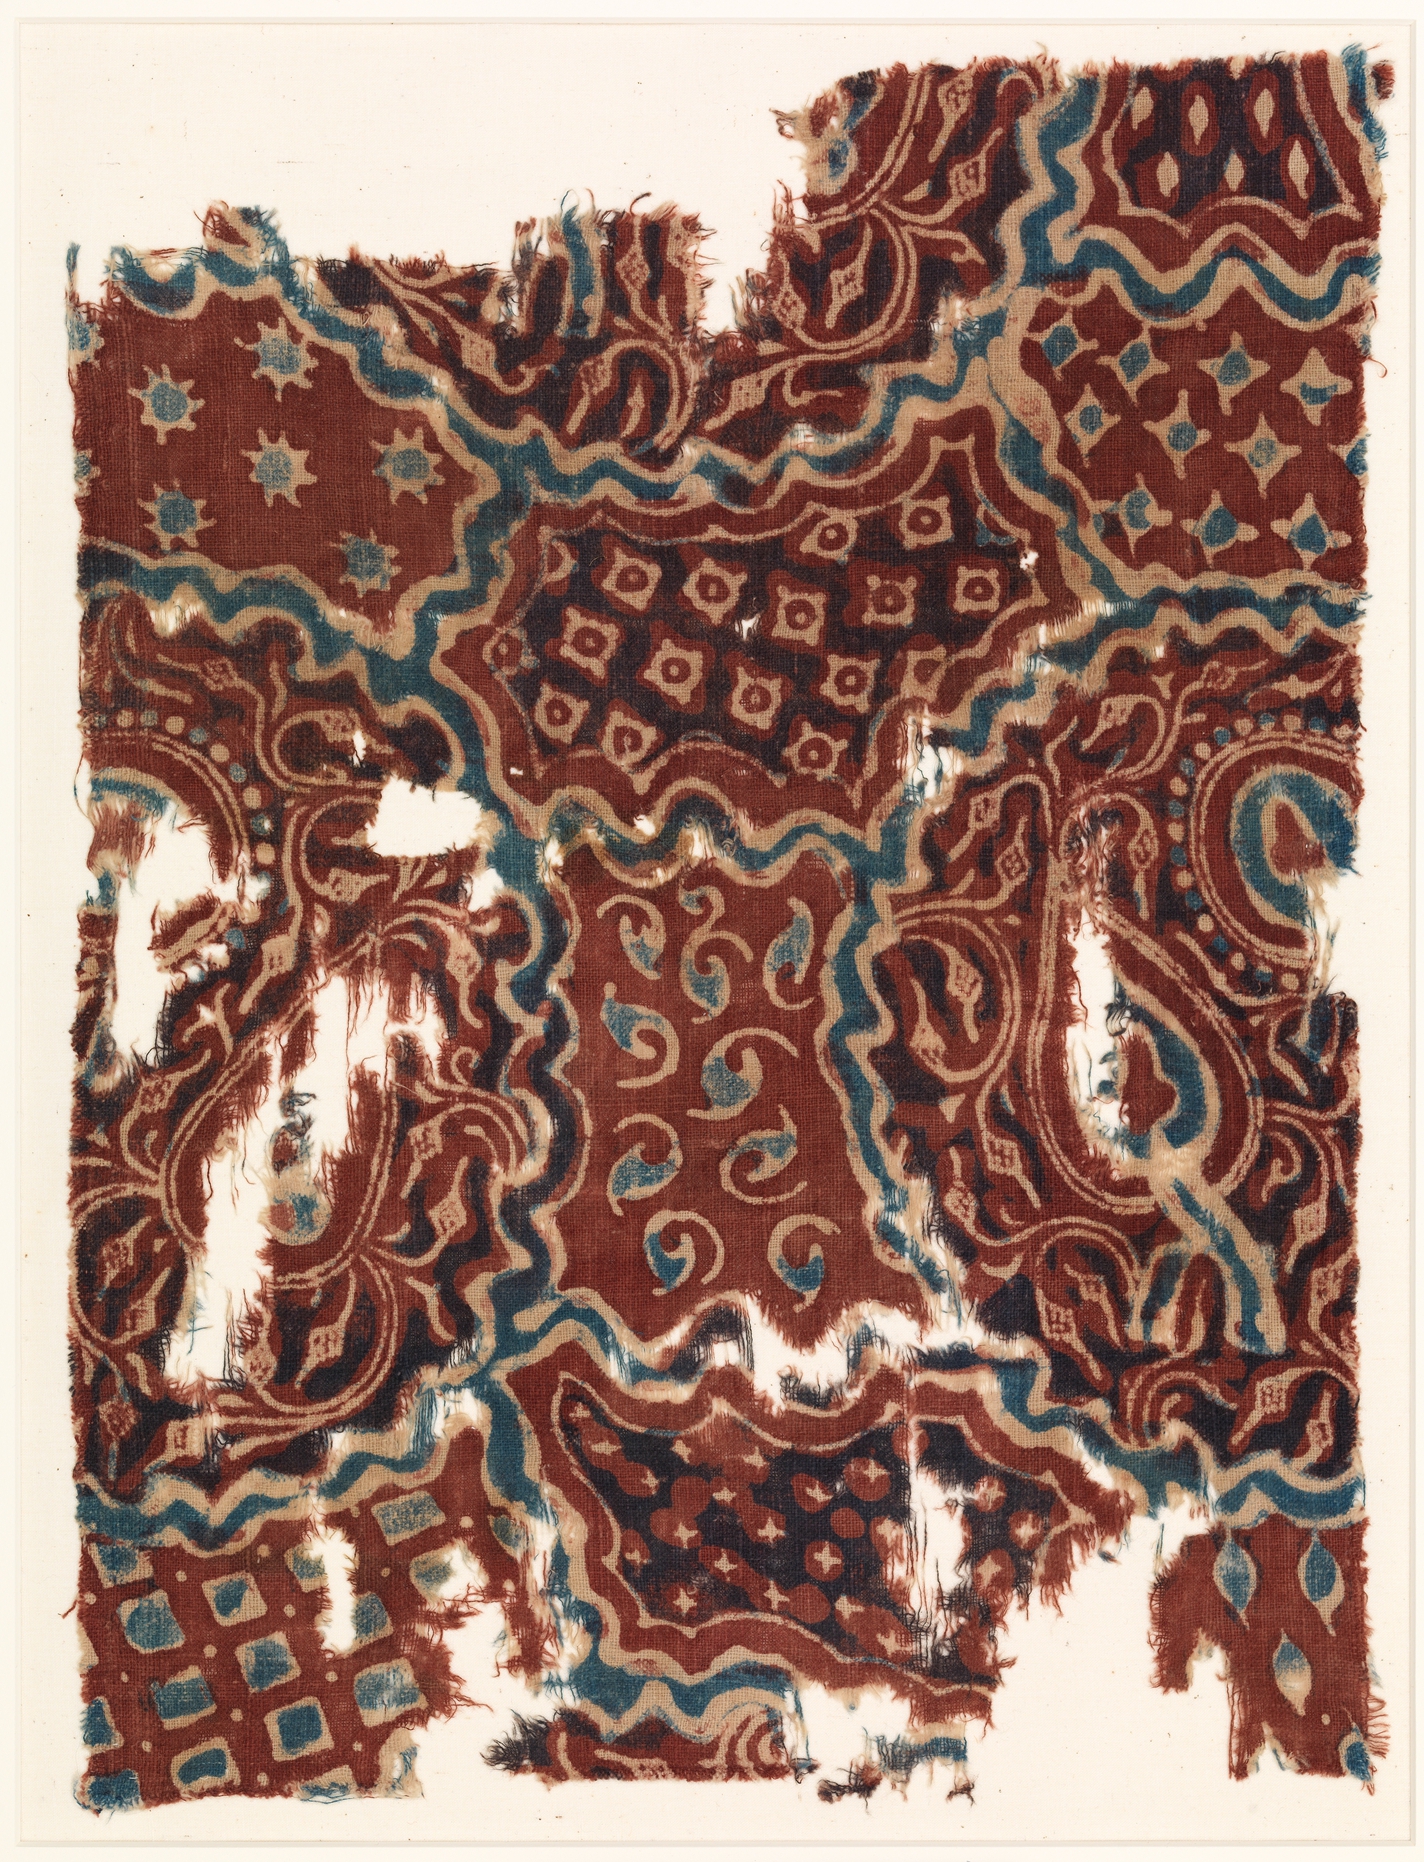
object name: textile fragment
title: Fragment of Textile with a Forested Landscape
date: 1301-1400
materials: cotton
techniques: dyeing, painting, weave, printing, resist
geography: egypt